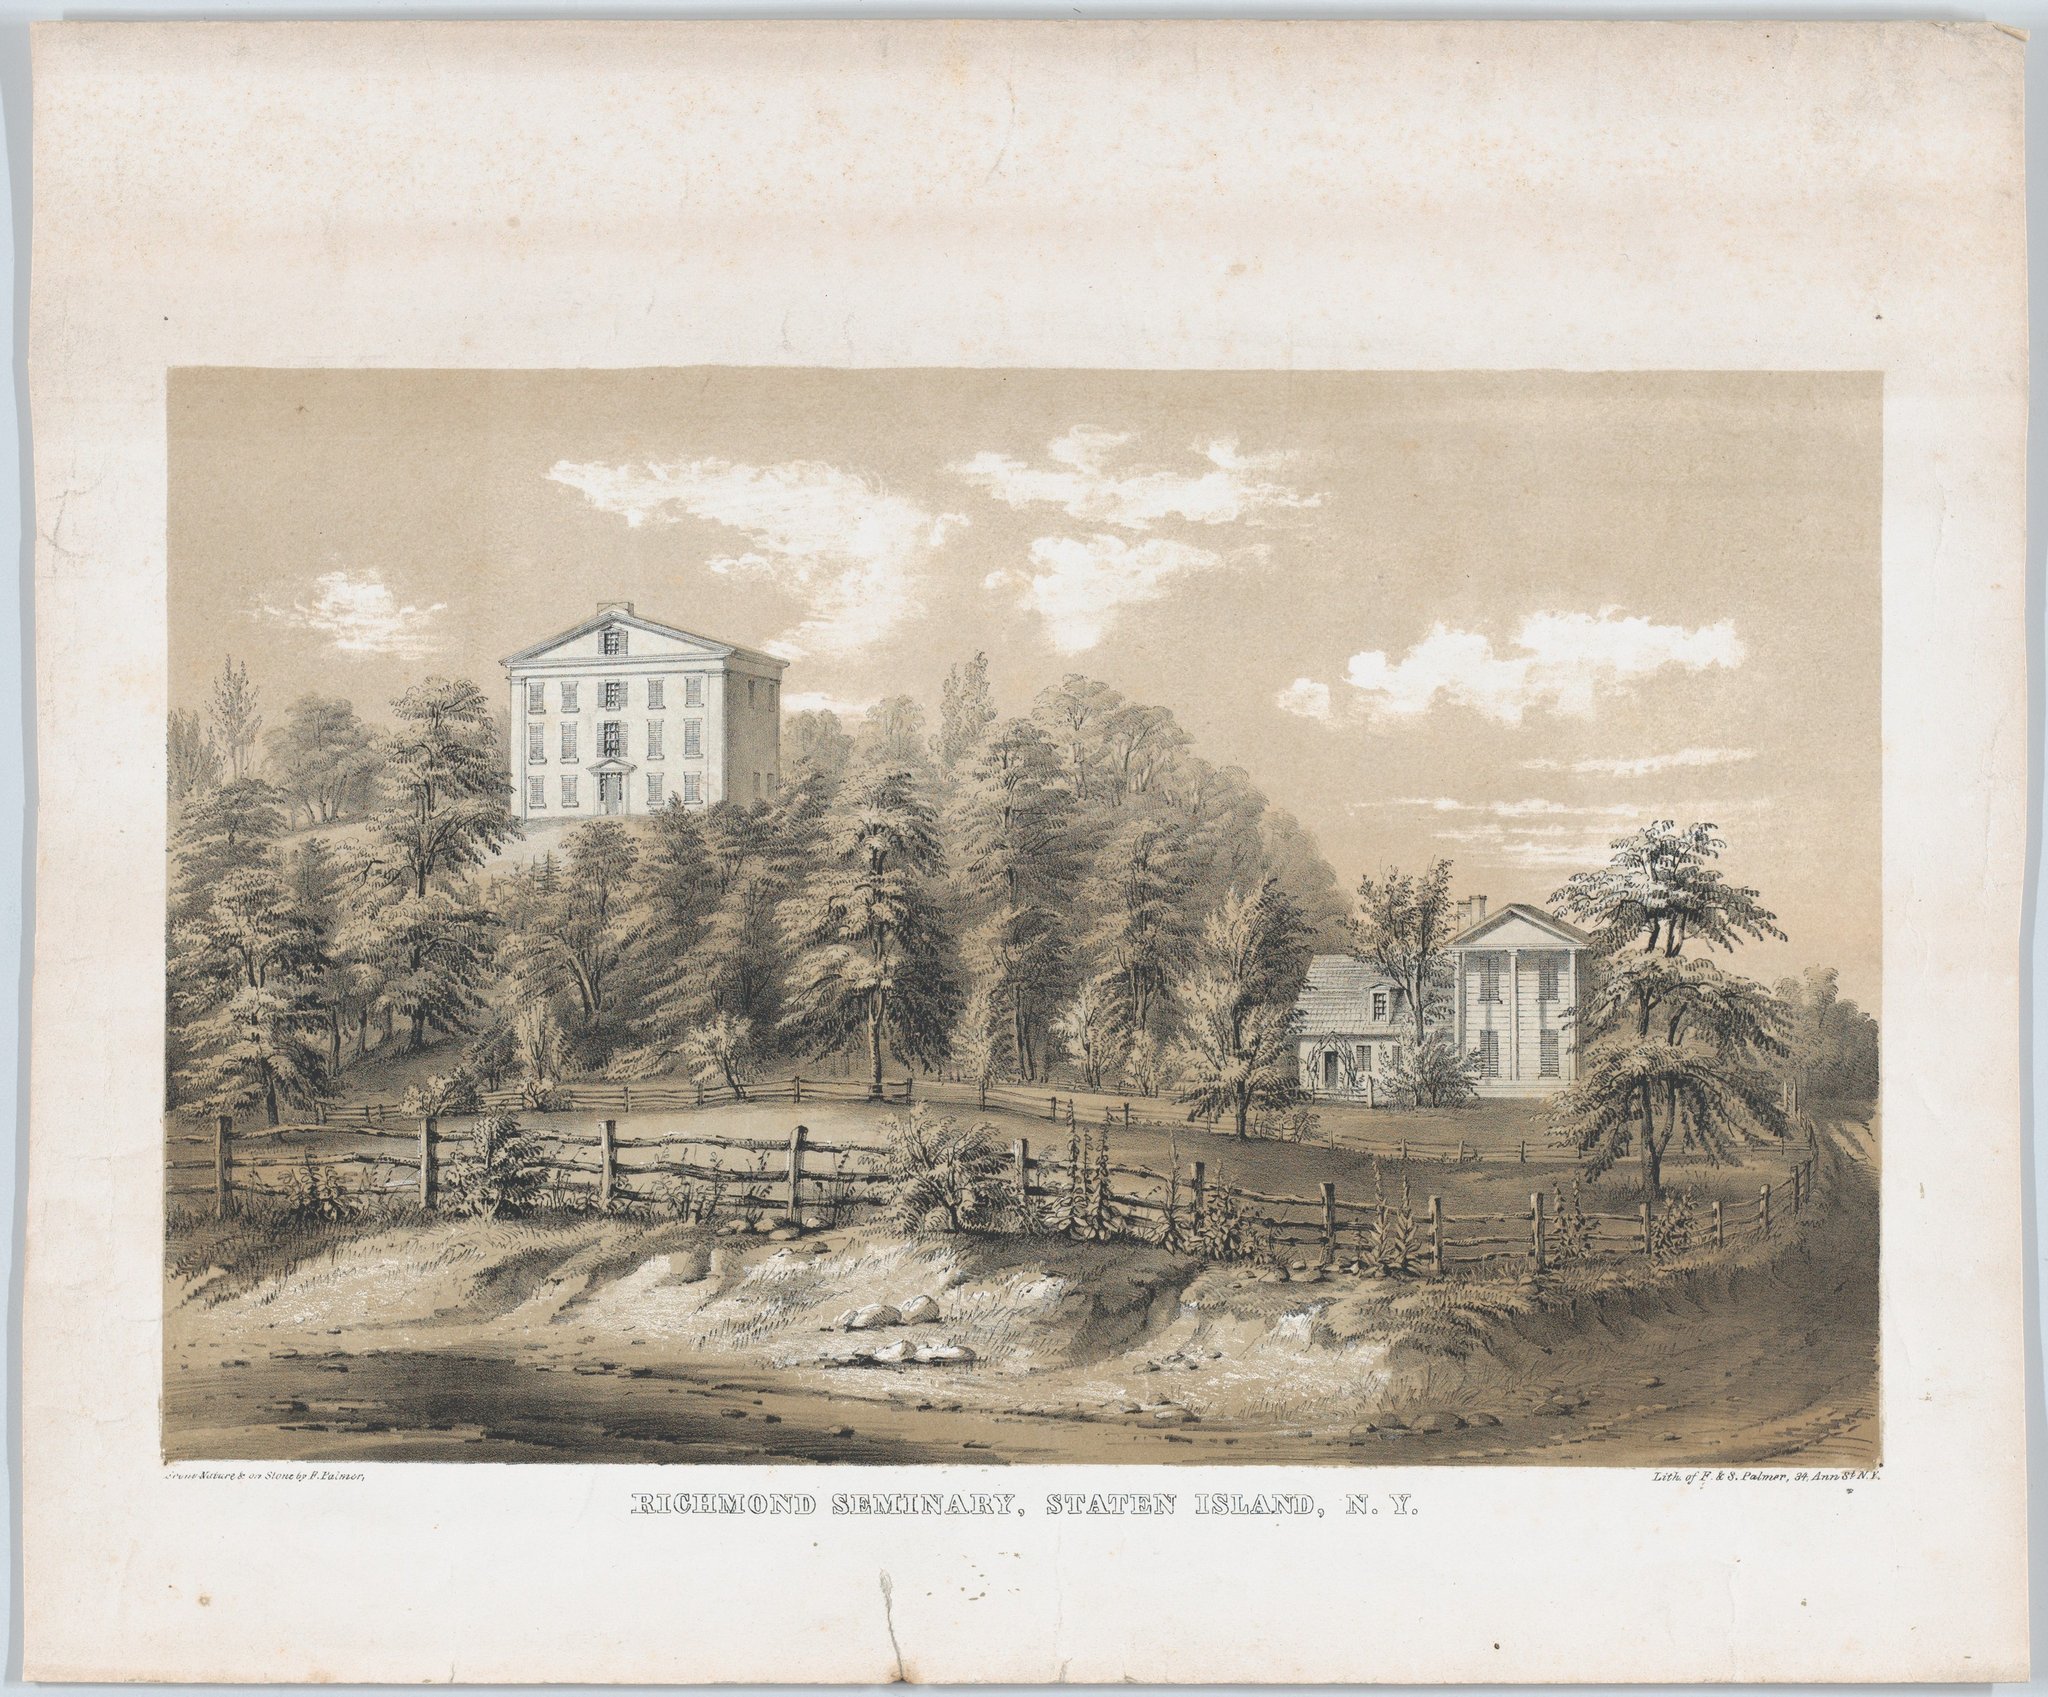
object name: print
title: Richmond Seminary, Staten Island, N.Y.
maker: frances flora bond palmer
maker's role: artist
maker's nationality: american, born england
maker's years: 1812-1876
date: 1847-1848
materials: stone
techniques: hand coloring, lithograph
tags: buildings,trees